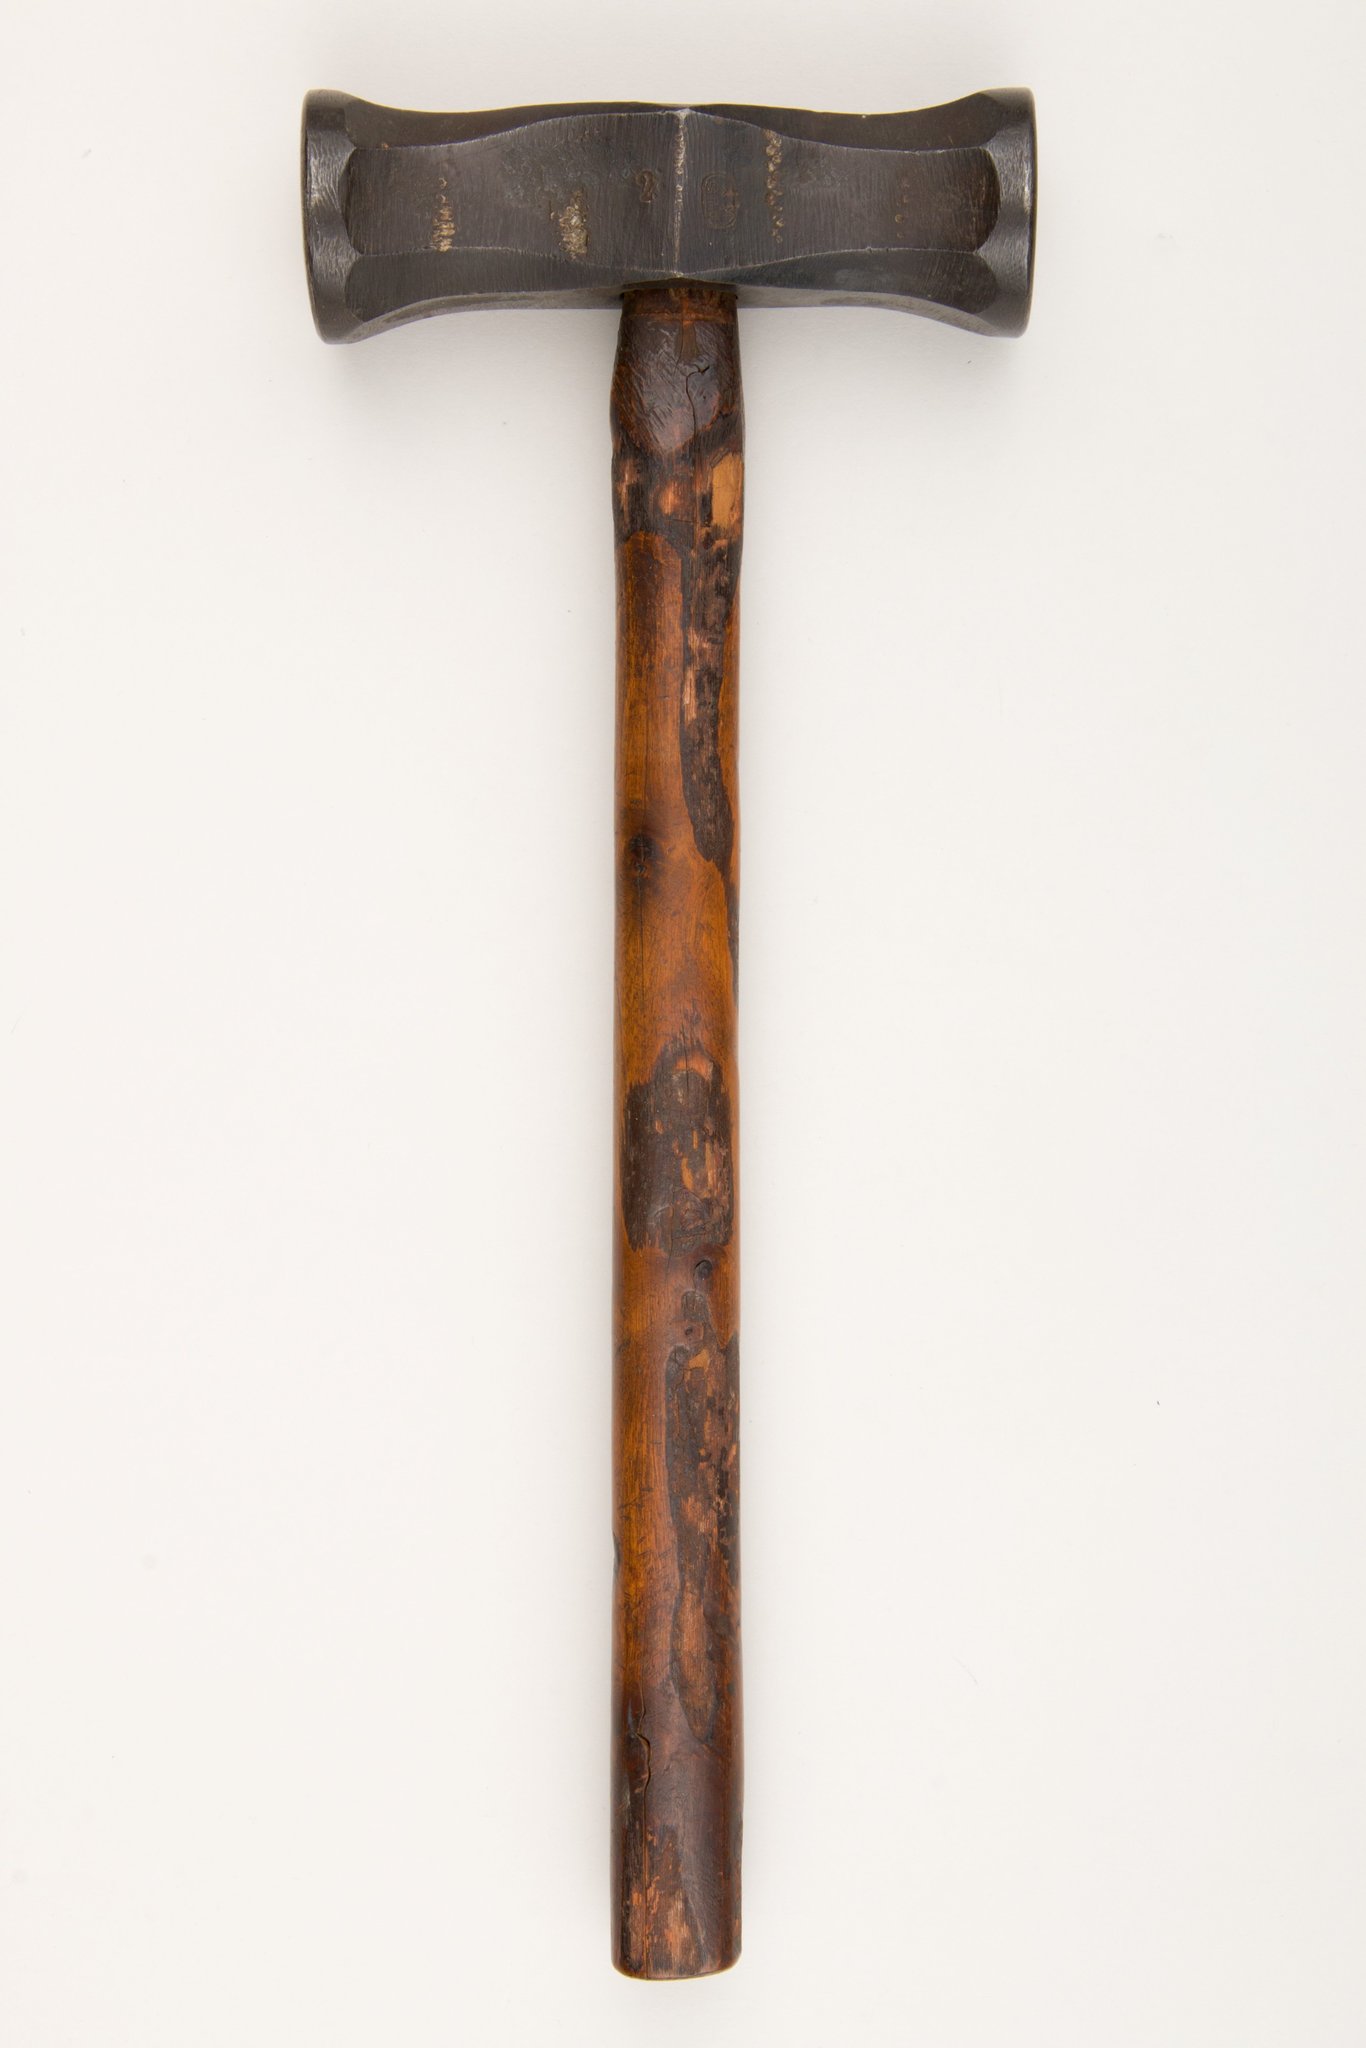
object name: armorer's hammer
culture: french or german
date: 1701-1900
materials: iron, wood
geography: germany